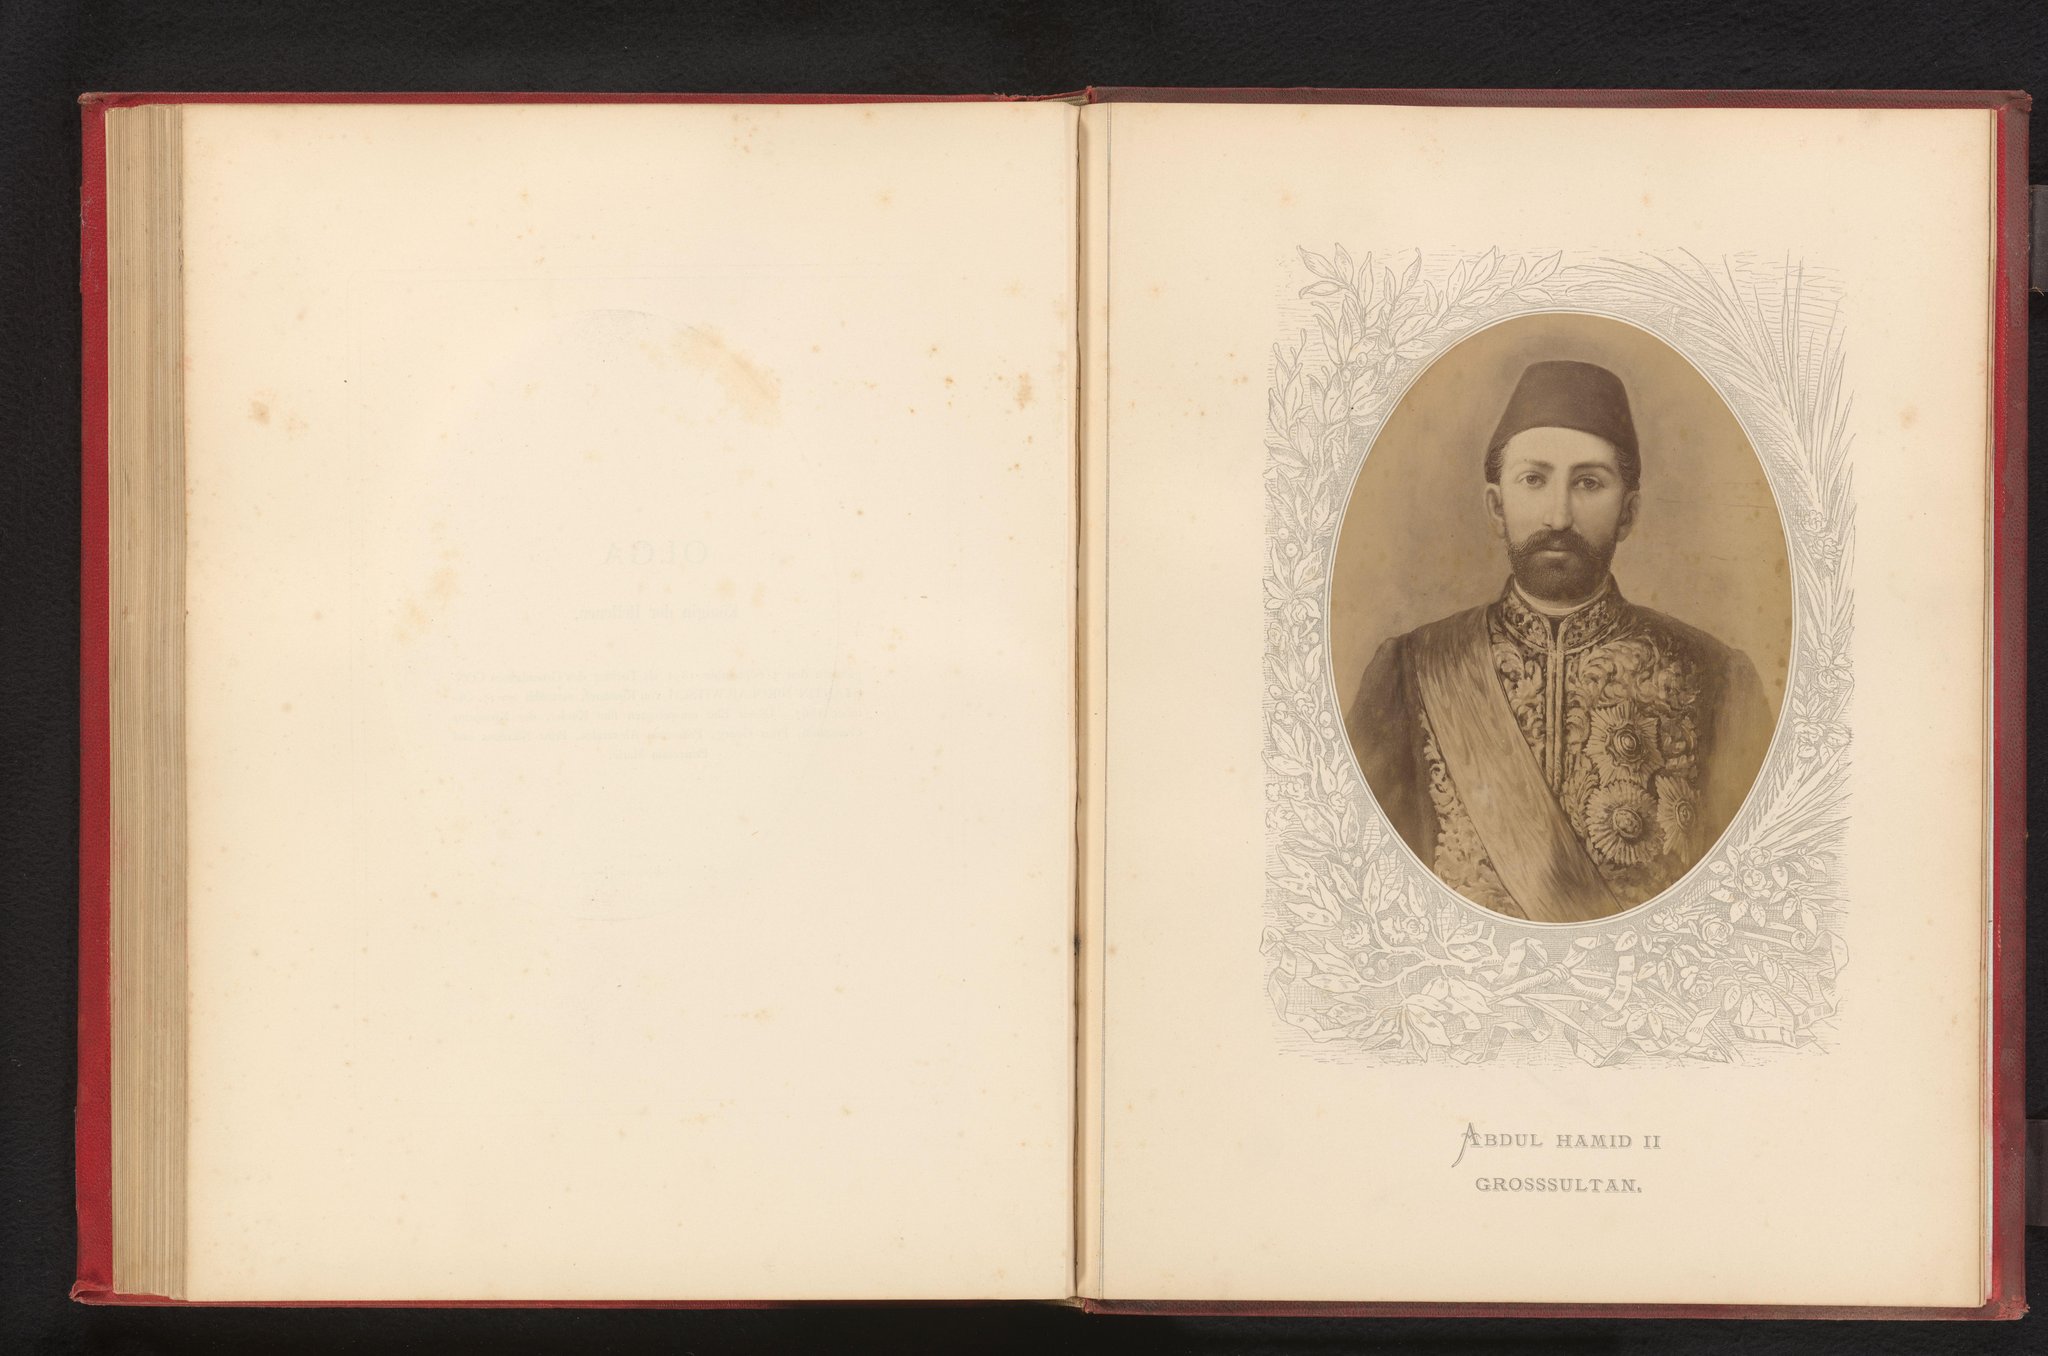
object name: page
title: Fotoreproductie van een geschilderd portret van Abdülhamid II, sultan van het Ottomaanse Rijk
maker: Anonymous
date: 1875-1880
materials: paper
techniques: albumen print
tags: historical persons, emperor